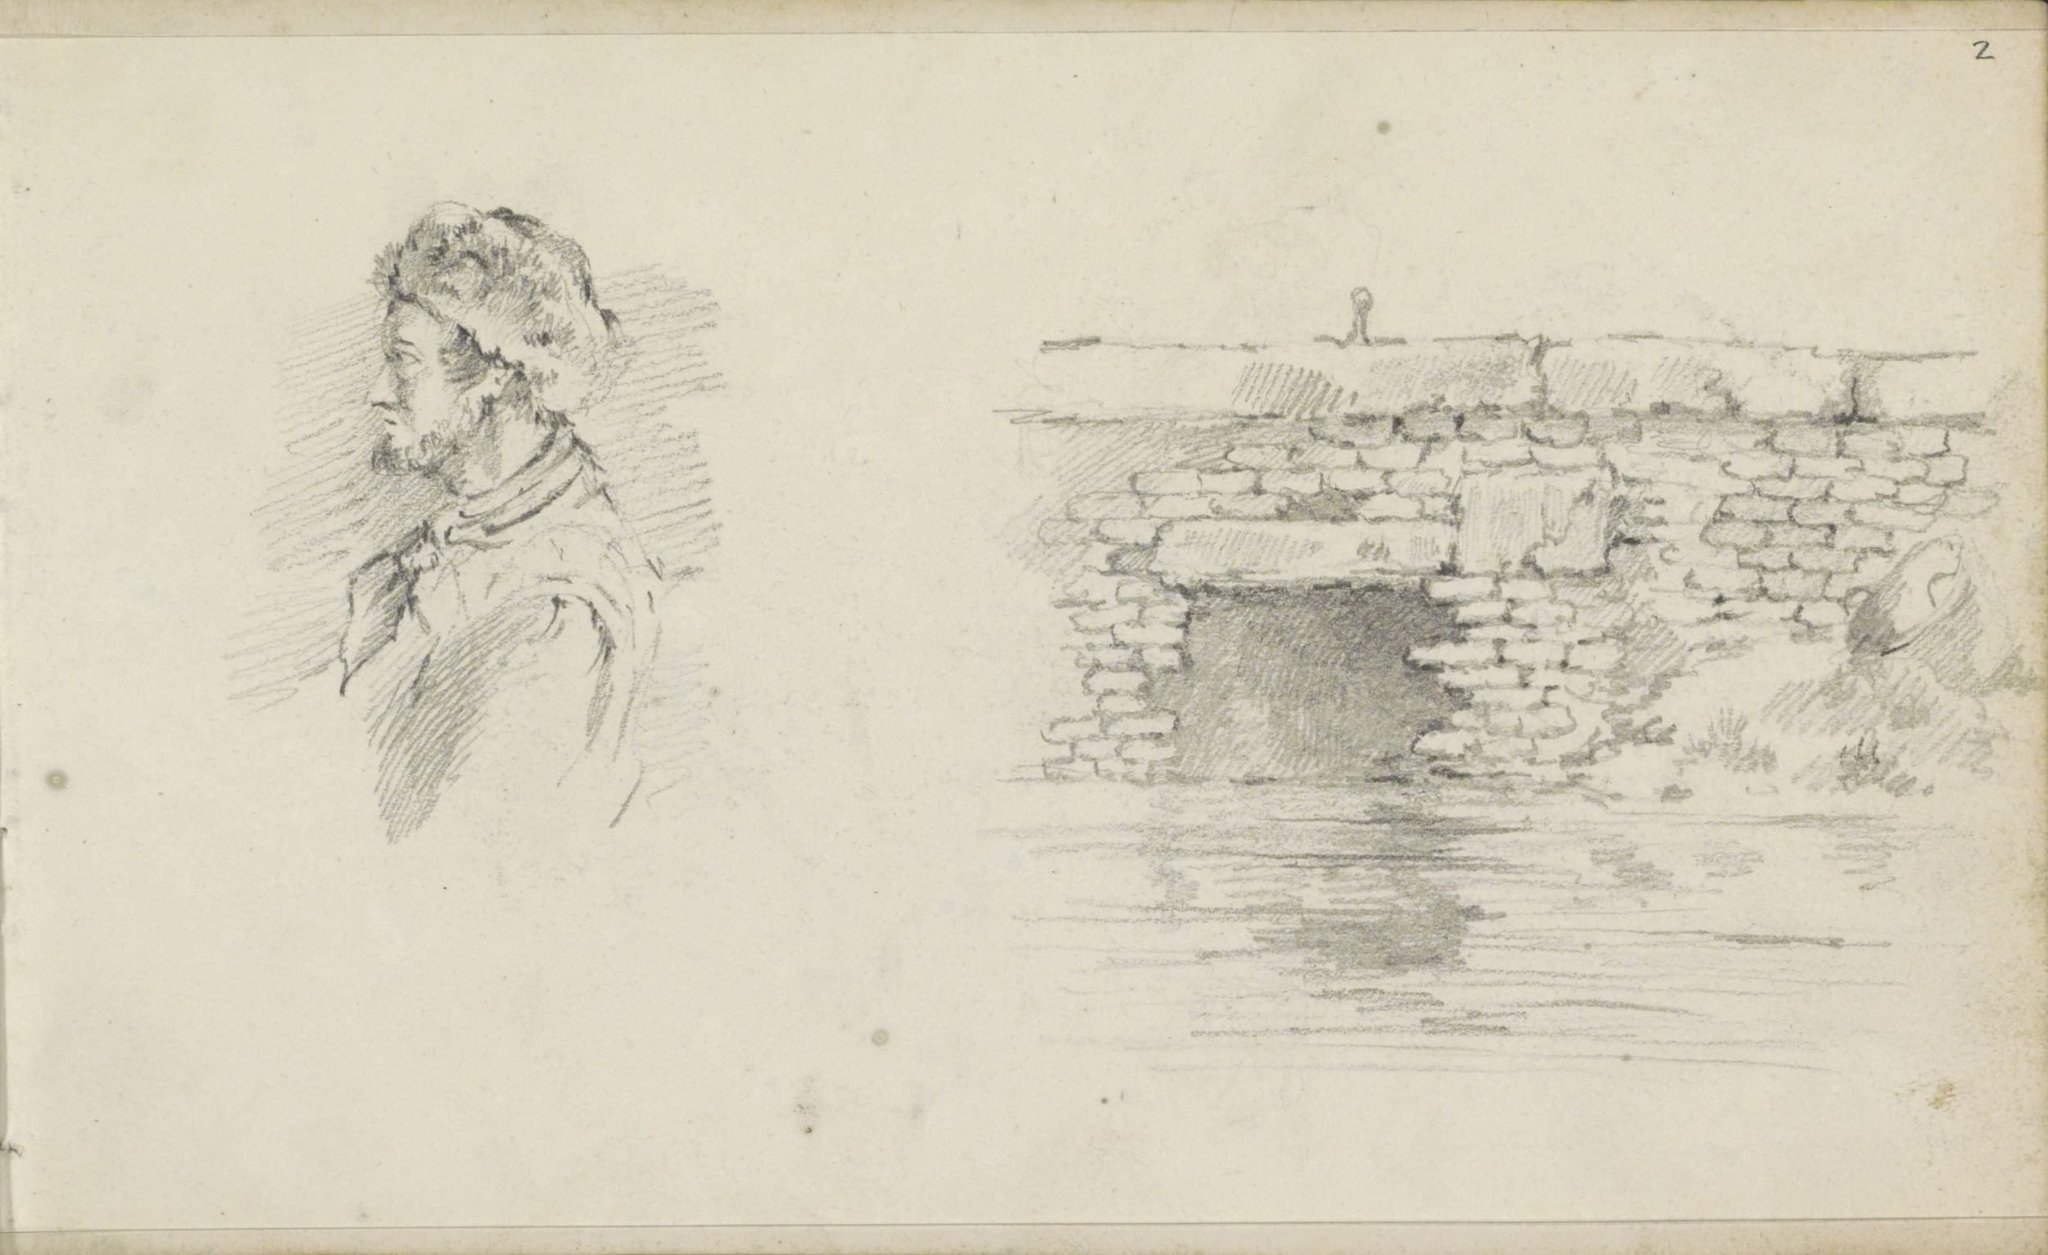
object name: sketchbook leaf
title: Man met bontmuts en een brug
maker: adrianus eversen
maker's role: draughtsman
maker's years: 1818-1897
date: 1828-1897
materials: paper, pencil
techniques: stumping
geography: netherlands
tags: head-gear, adult man (+ sideview, profile), bridge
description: Links een portret van een onbekende man met een geknoopte halsdoek en een bontmuts, in profiel naar links. Rechts een stenen brug. Bij de brug ligt een voorwerp, mogelijk een teil of tobbe. Blad 2 recto uit een schetsboek met 27 bladen.